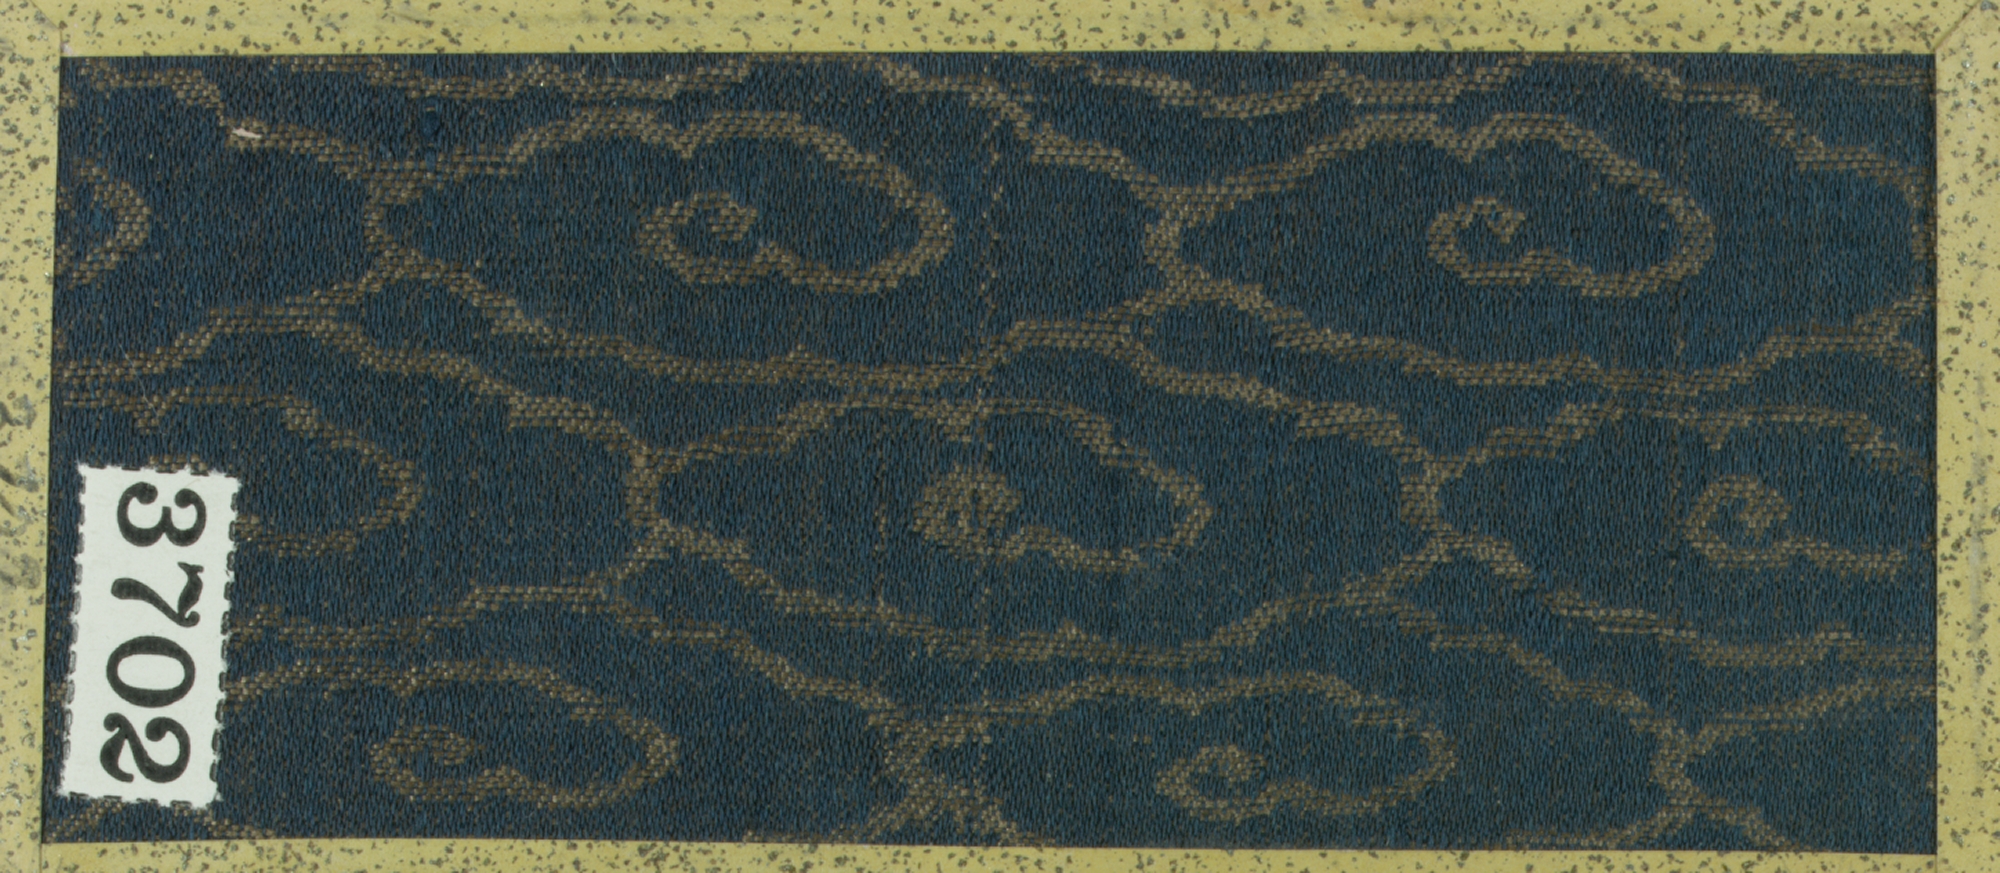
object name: sample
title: Textile Sample from Sample Book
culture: japanese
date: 1801-1900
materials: silk